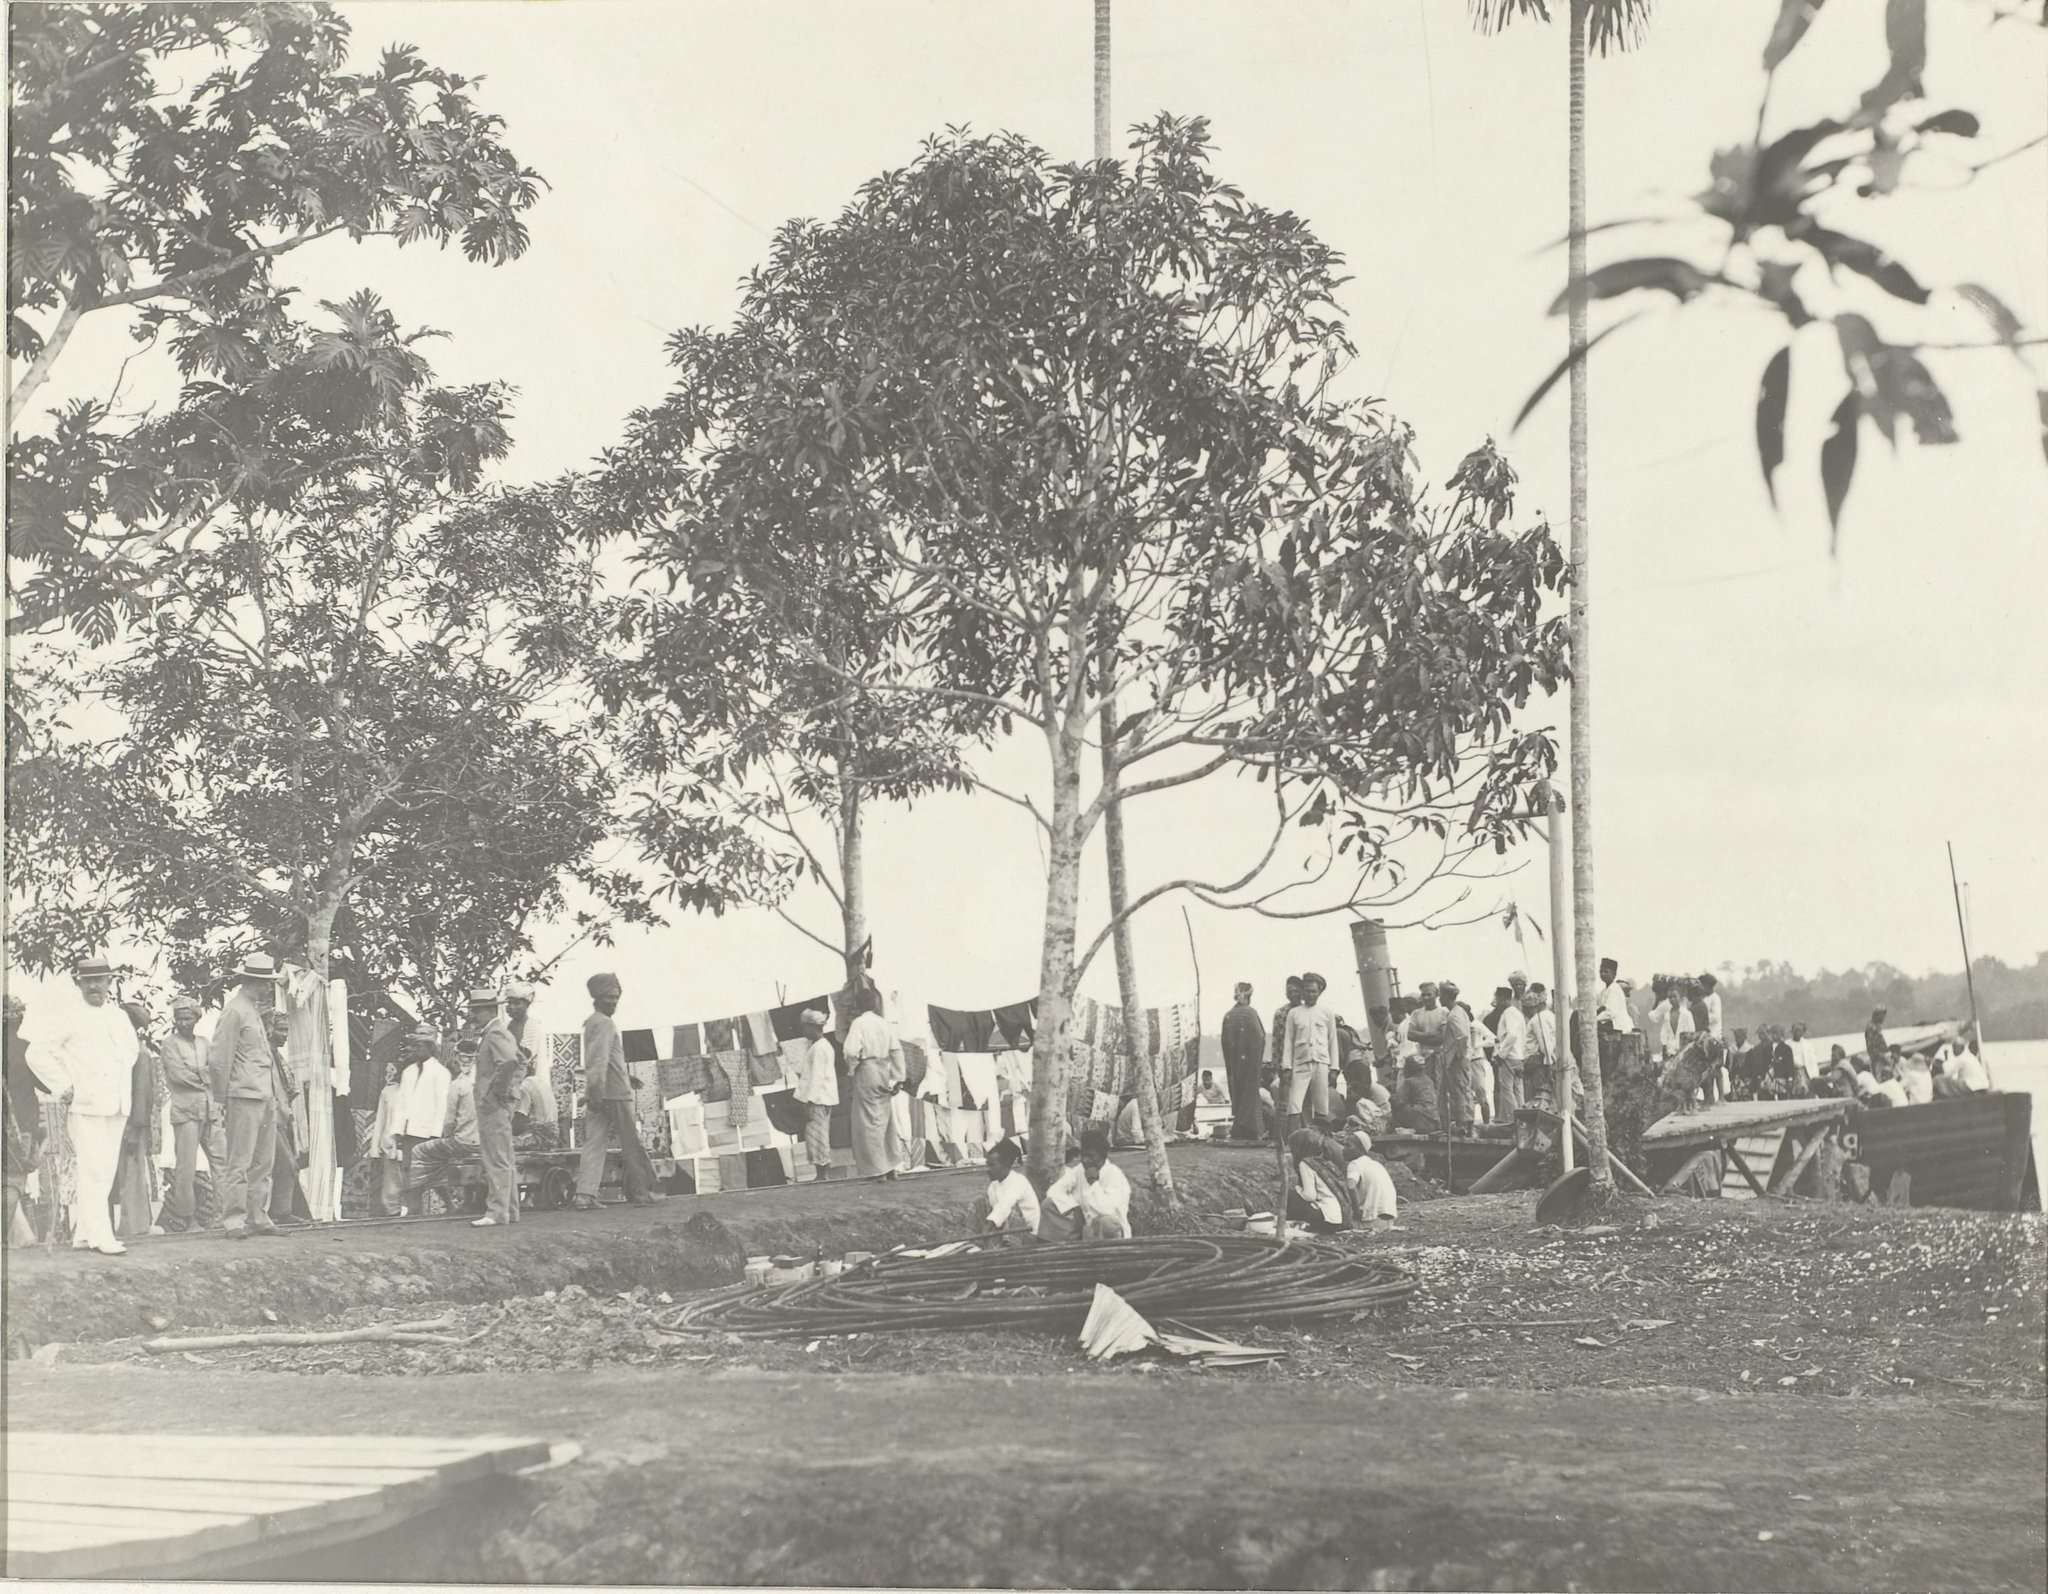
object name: album leaf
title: Textielmarkt aan een rivier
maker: Anonymous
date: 1903-1907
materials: paper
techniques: gelatin silver print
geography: kalimantan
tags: river, market, borneo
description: Textielmarkt bezocht door Europeanen en lokale inwoners aan de oever van een rivier op Borneo. Foto in het fotoalbum over de oliewinning op Borneo door de Koninklijke Nederlandsche Petroleum Maatschappij (KNPM) in de jaren 1903-1907.